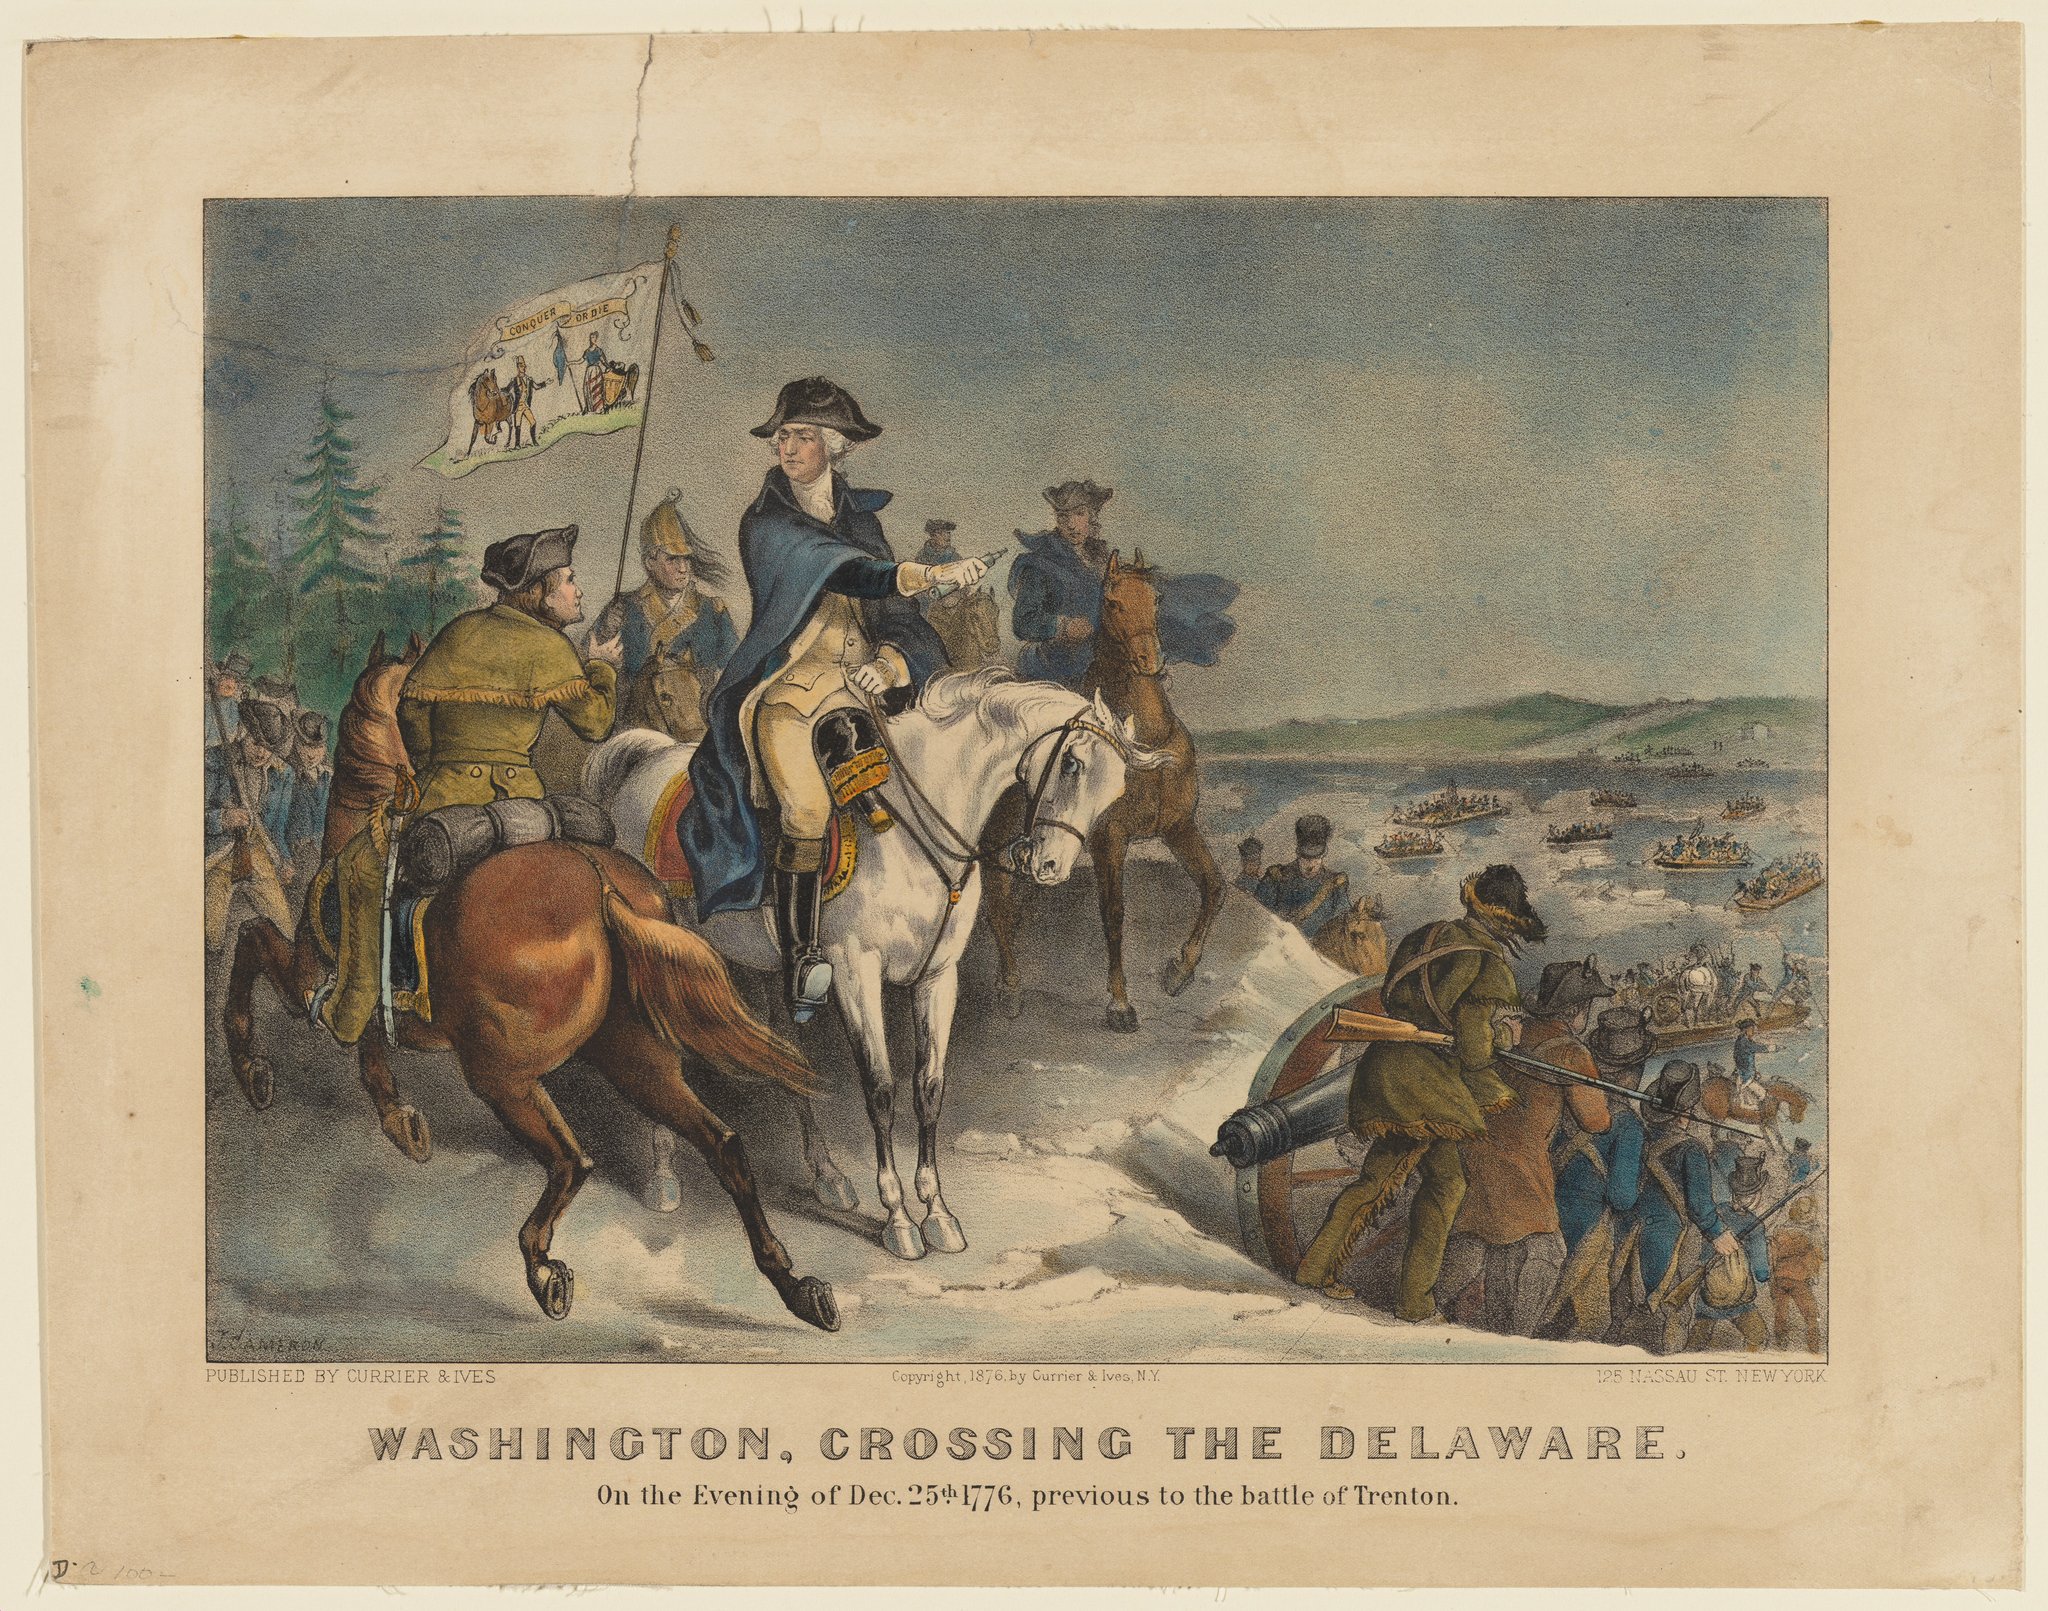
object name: print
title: Washington, Crossing the Delaware–On the Evening of Dec. 25th 1776, previous to the Battle of Trenton.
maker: currier & ives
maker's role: publisher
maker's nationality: american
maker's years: 1857-1907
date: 1876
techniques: hand coloring, lithograph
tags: soldiers,american revolution,george washington,horses,boats